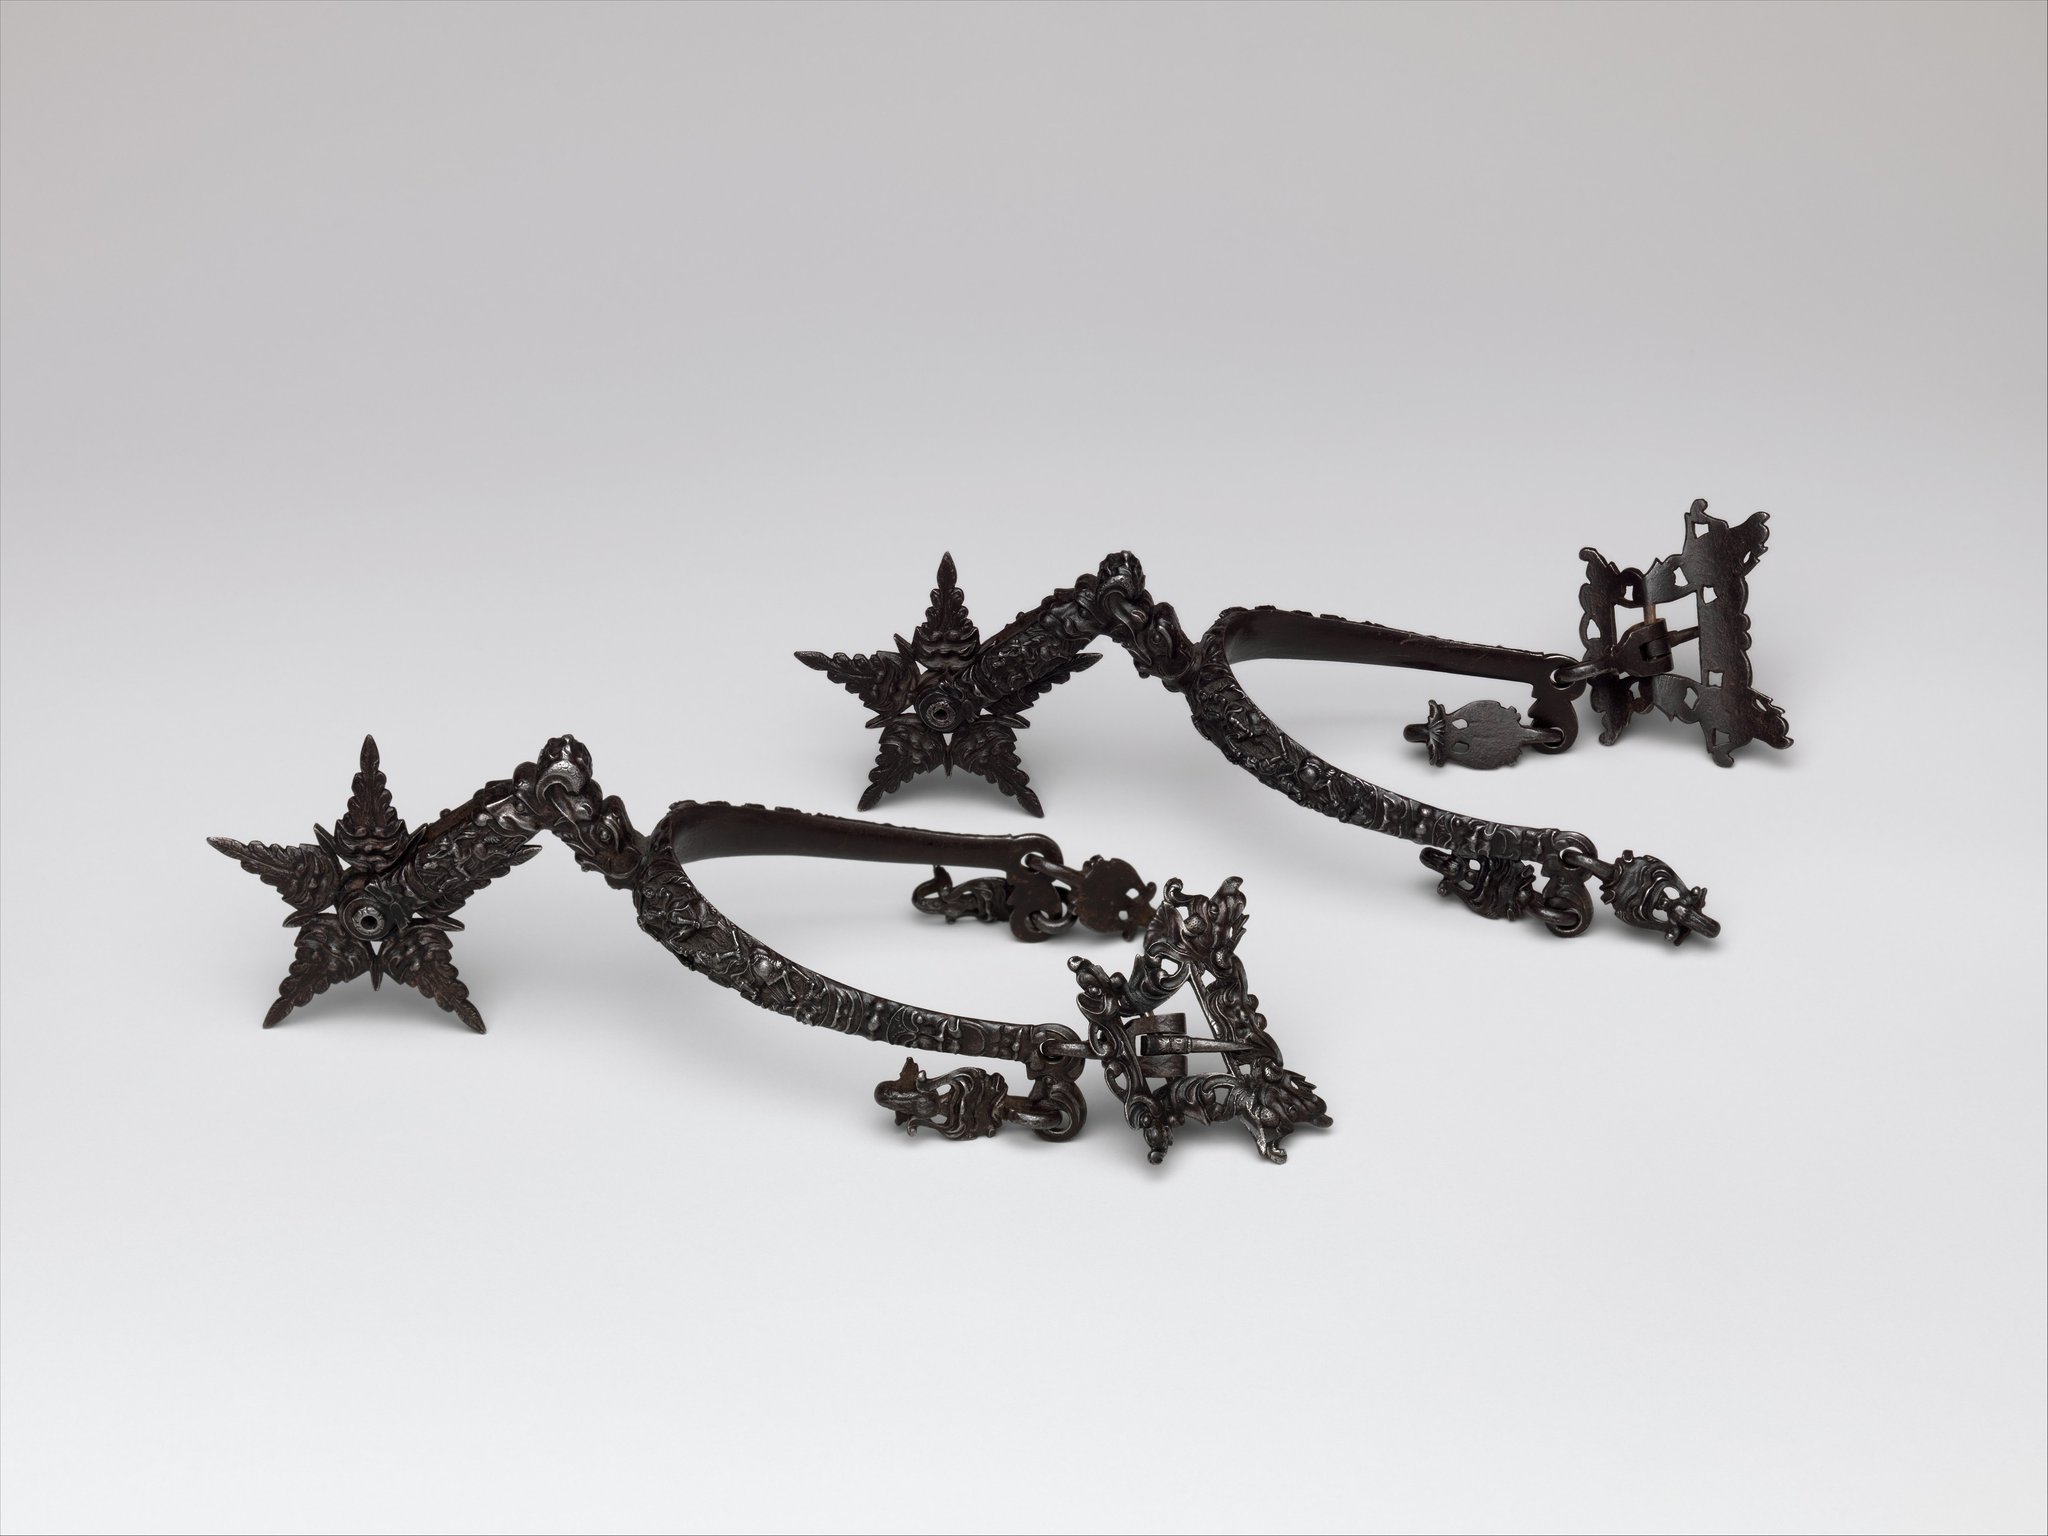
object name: spur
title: Pair of Rowel Spurs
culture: dutch or french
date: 1650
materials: iron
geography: france